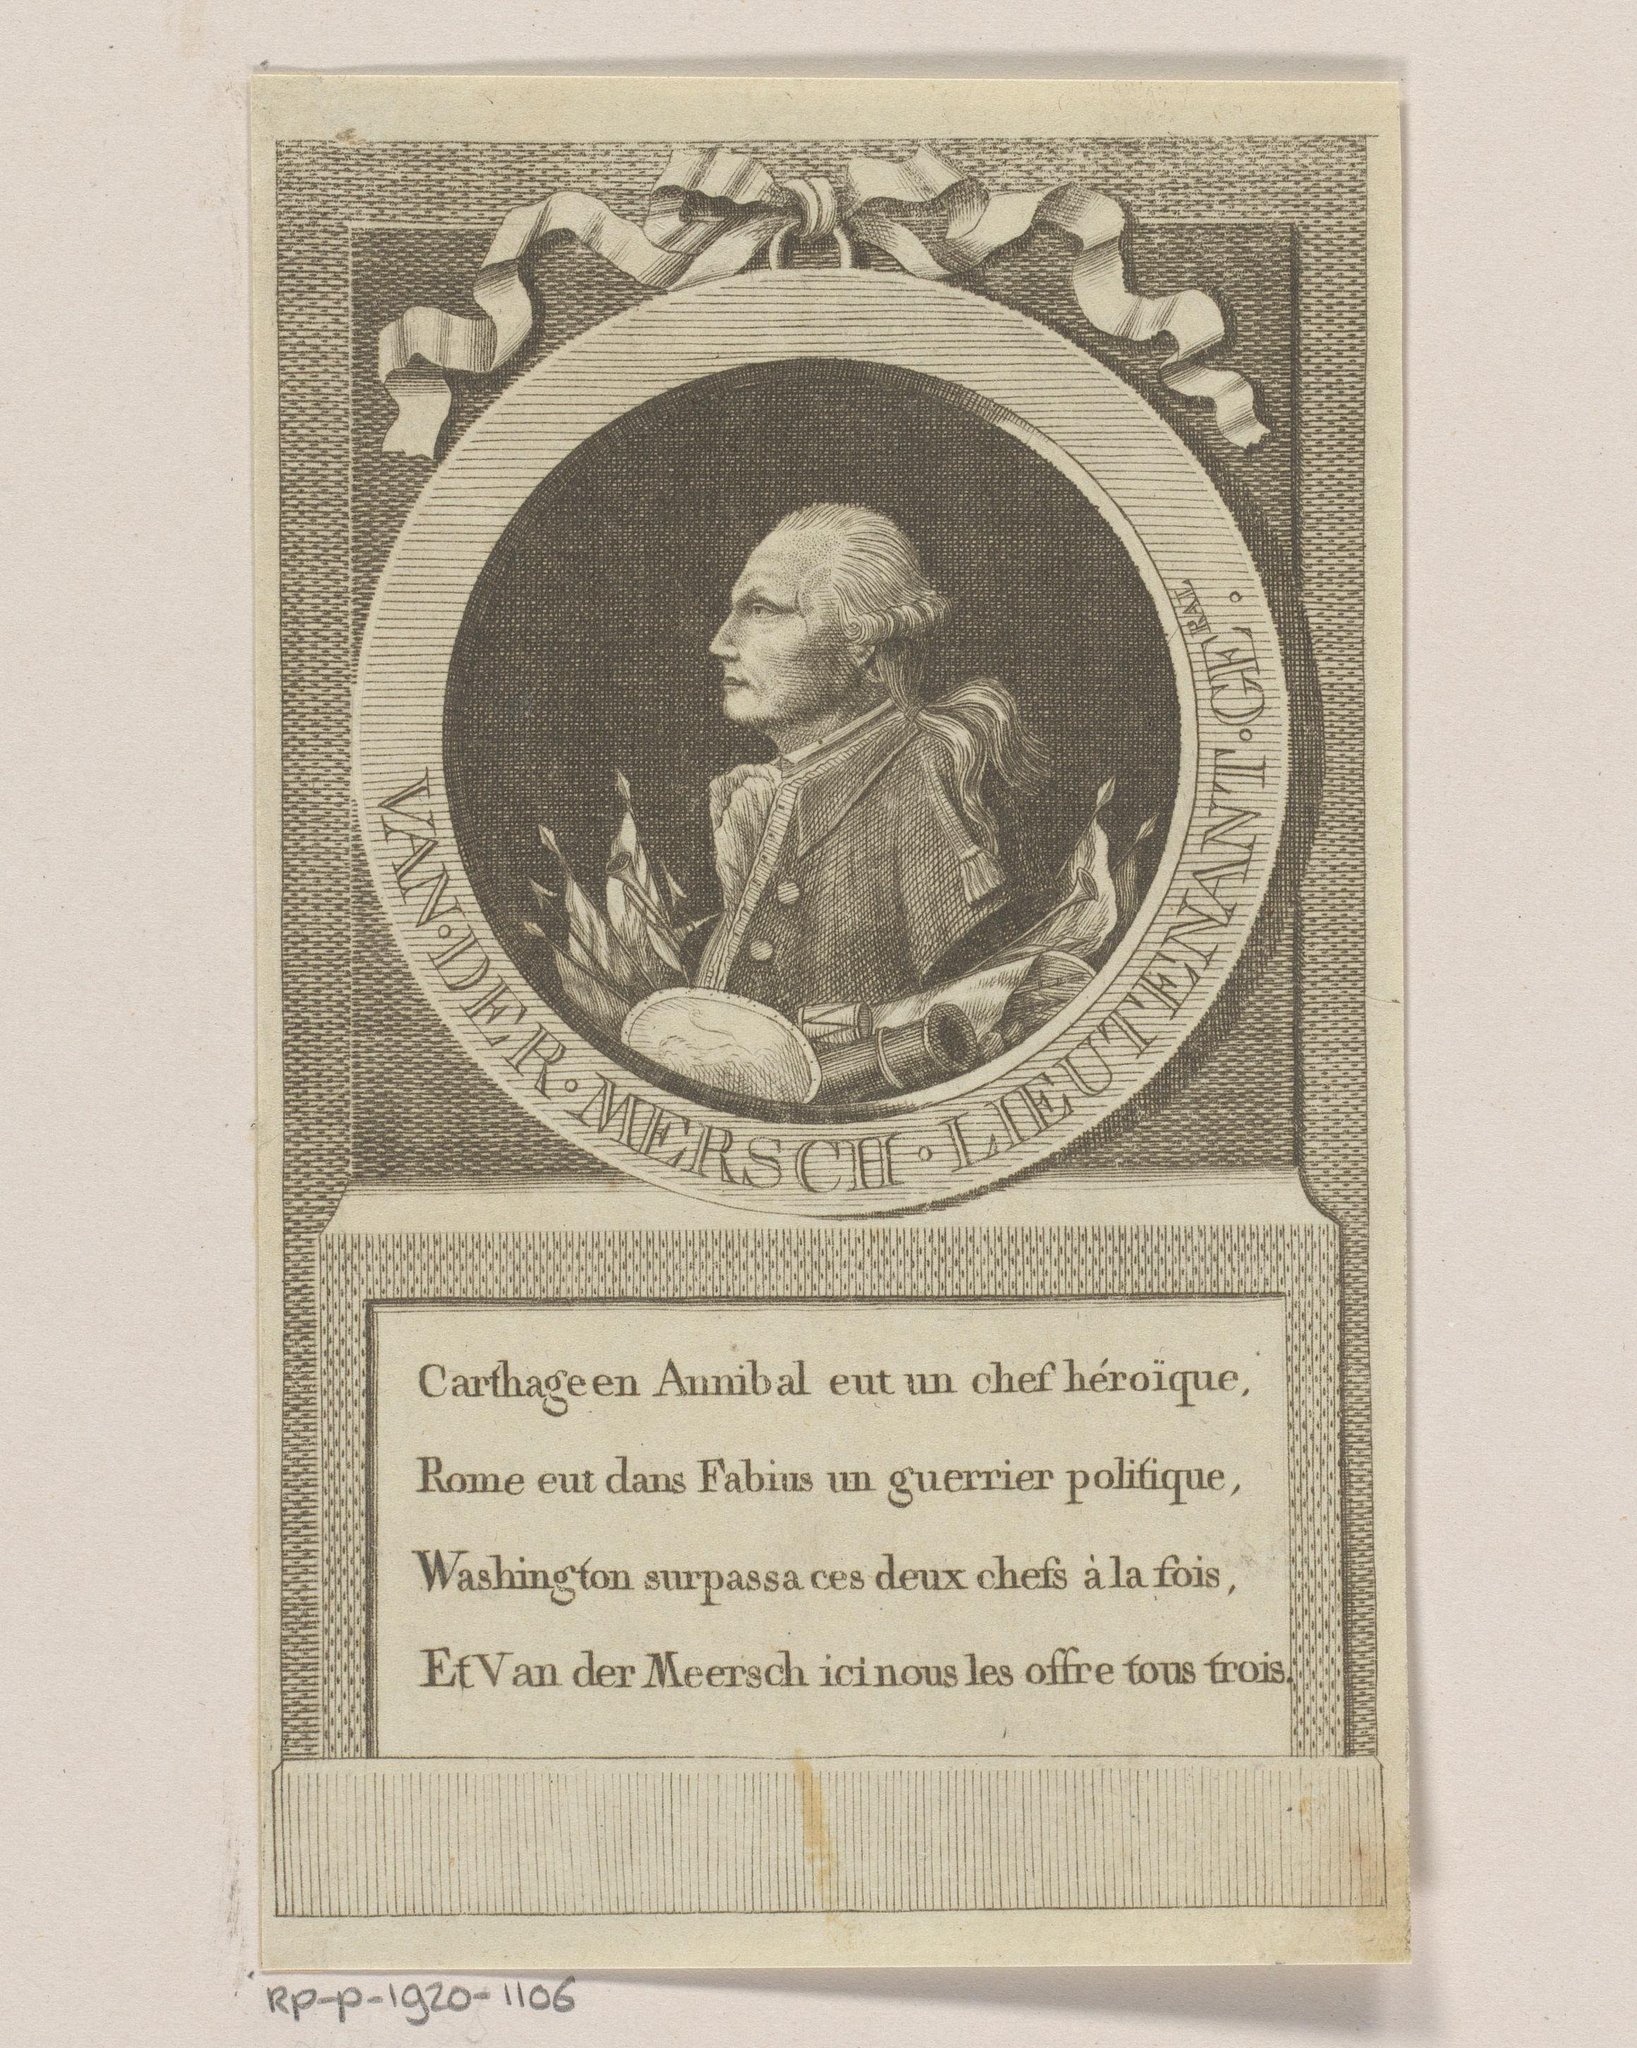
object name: print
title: Portret van Jan Andries vander Mersch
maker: Anonymous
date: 1789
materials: paper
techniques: engraving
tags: commander-in-chief, general, marshal, historical persons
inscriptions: collector's mark: Lugt 2228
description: Prent waarschijnlijk uit: Mercure flandrico-latino-gallico-belgique (...). Parijs: Imprimerie Patriotique, 1789, dl. 1.